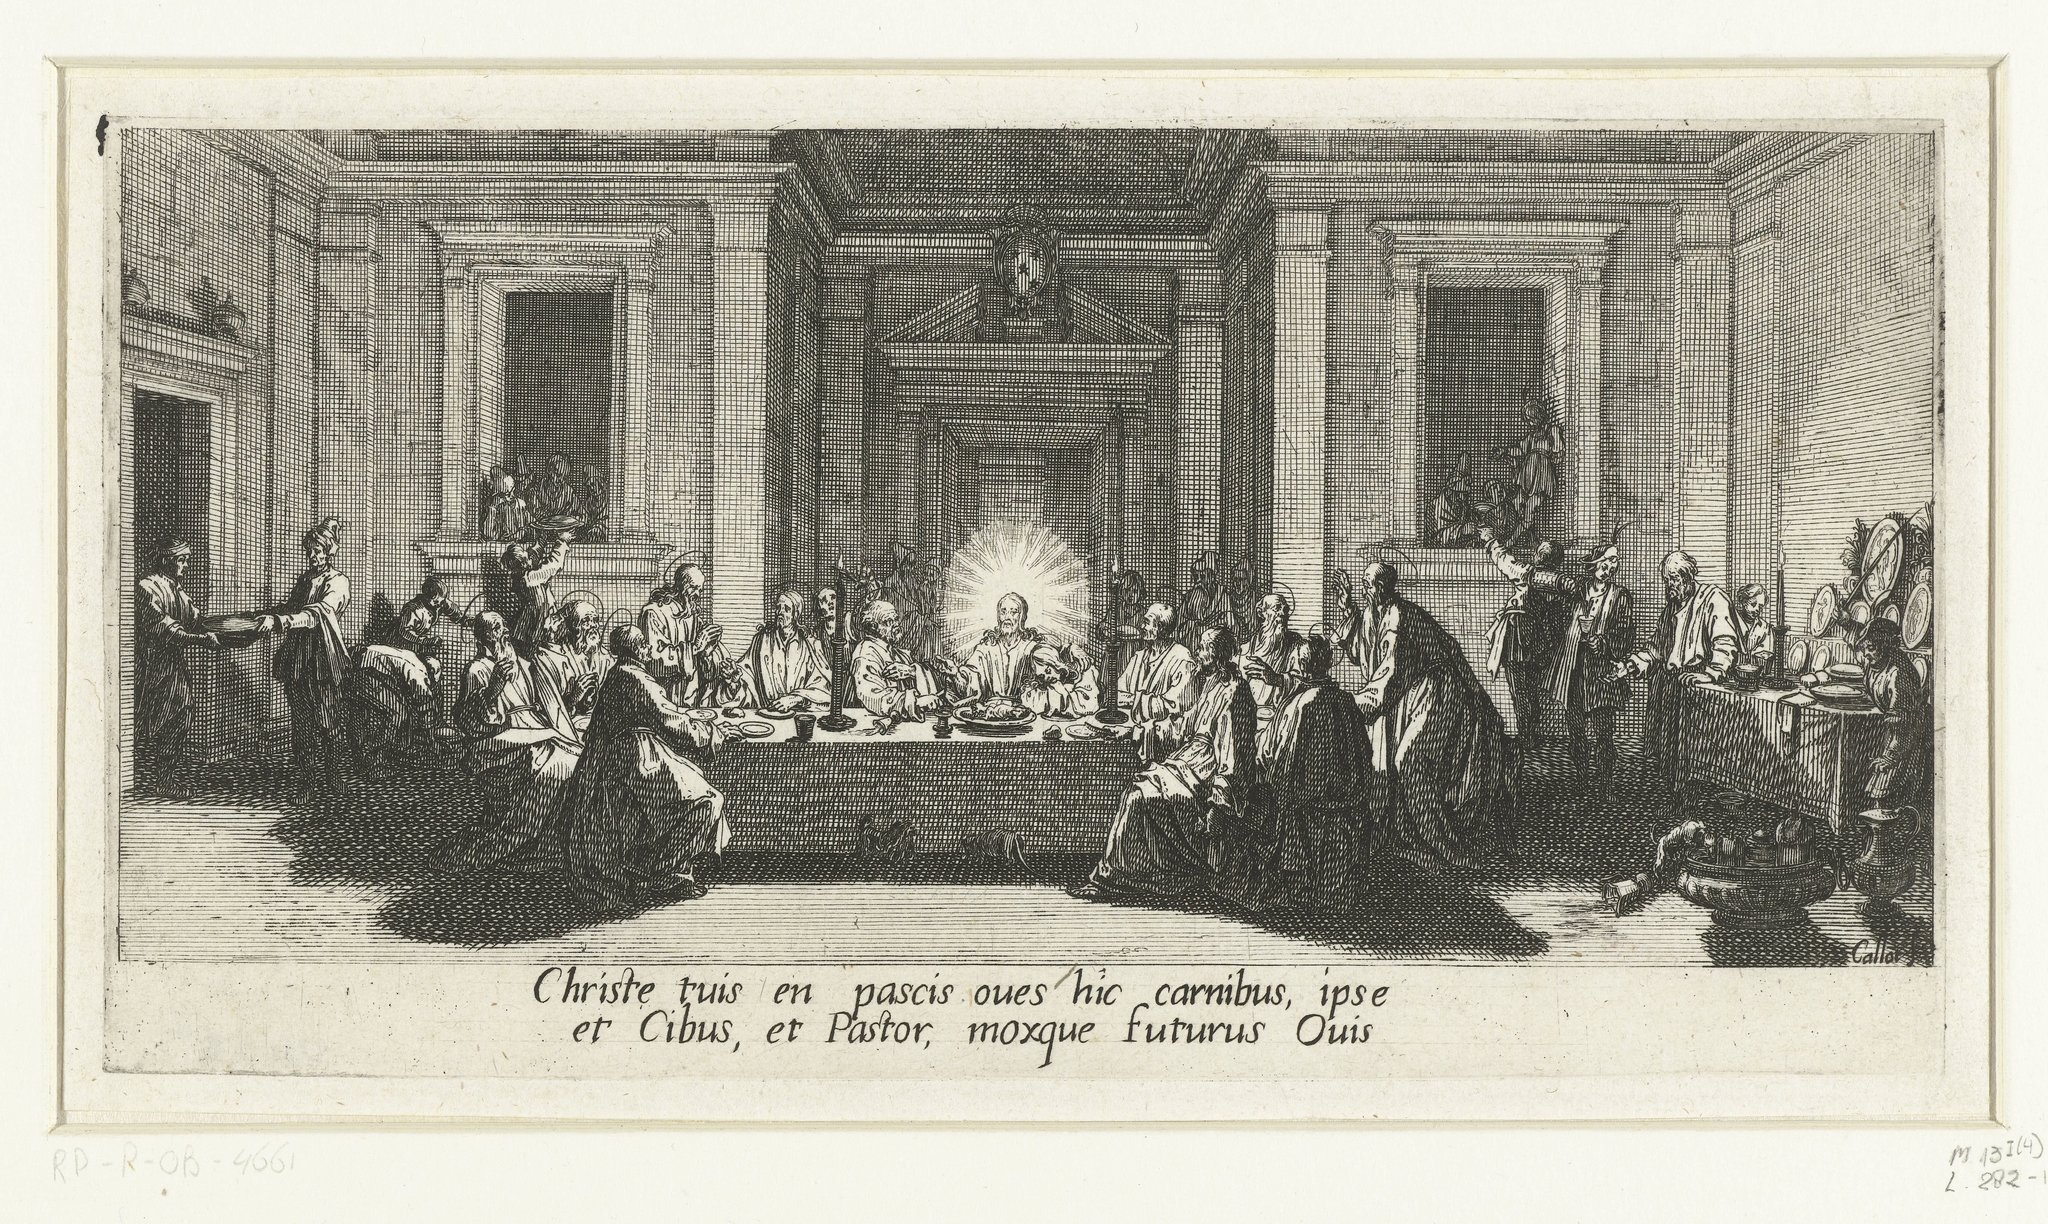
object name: print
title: Laatste Avondmaal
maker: jacques callot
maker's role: draughtsman, print maker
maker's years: 1592-1635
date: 1619-1624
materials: paper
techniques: engraving, etching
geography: florence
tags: last supper (in general) (matthew 26:21-35; mark 14:18-31; luke 22:3, 22:15-23; john 13:21-38)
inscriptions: collector's mark: Lugt 240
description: In een ruime, klassiek ogende zaal zit Christus met zijn discipelen aan een lange tafel. Om hen heen staan en lopen nog enkele andere mensen. Deze prent is onderdeel van de onvoltooide prentserie 'De grote Passie', bestaande uit 7 scènes uit het Lijdensverhaal.